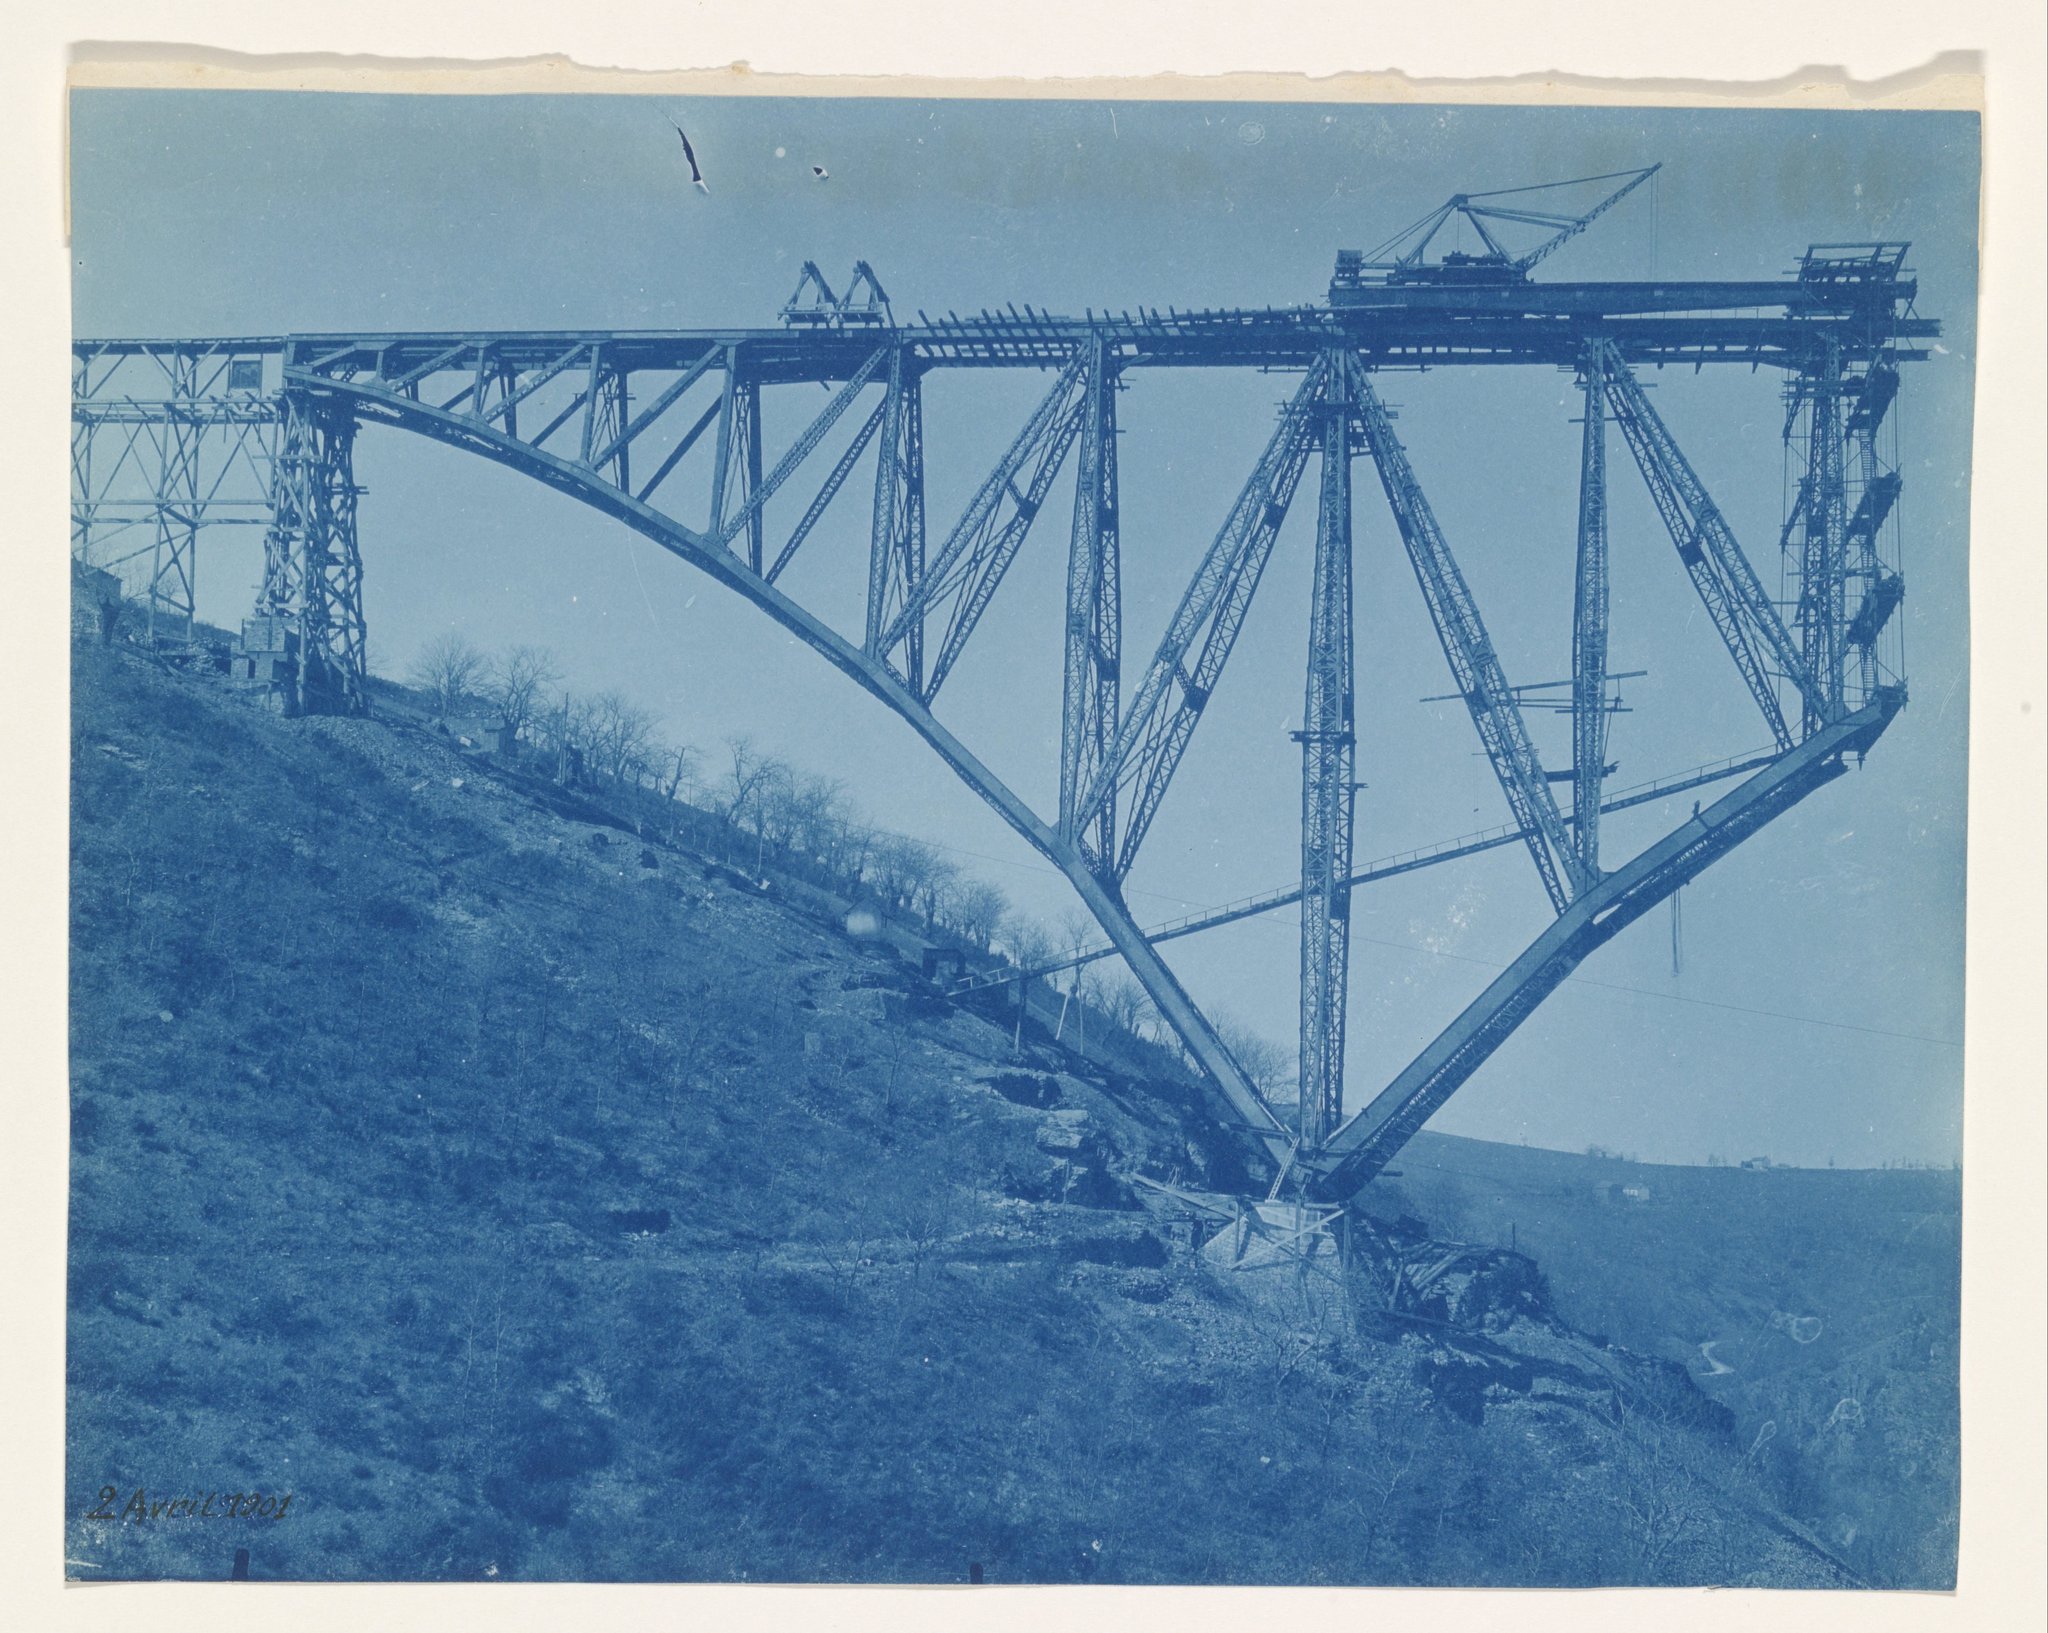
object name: photograph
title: Construction of the Viaur Viaduct in France by Societé de Construction des Battignolles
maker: Anonymous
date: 1901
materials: photographic support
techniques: cyanotype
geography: france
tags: viaduct, making the overground structures (~ building activities)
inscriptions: date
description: The Viaur Viaduct took seven years to build, from 1895 to 1902. Its progress was recorded every few months by a possibly local photographer. He must have carried out daredevil feats in the mountainous region in order to take good pictures of the bridge and its parts. In their time, these modernistic photographs were nothing more than helpful tools for the architects.